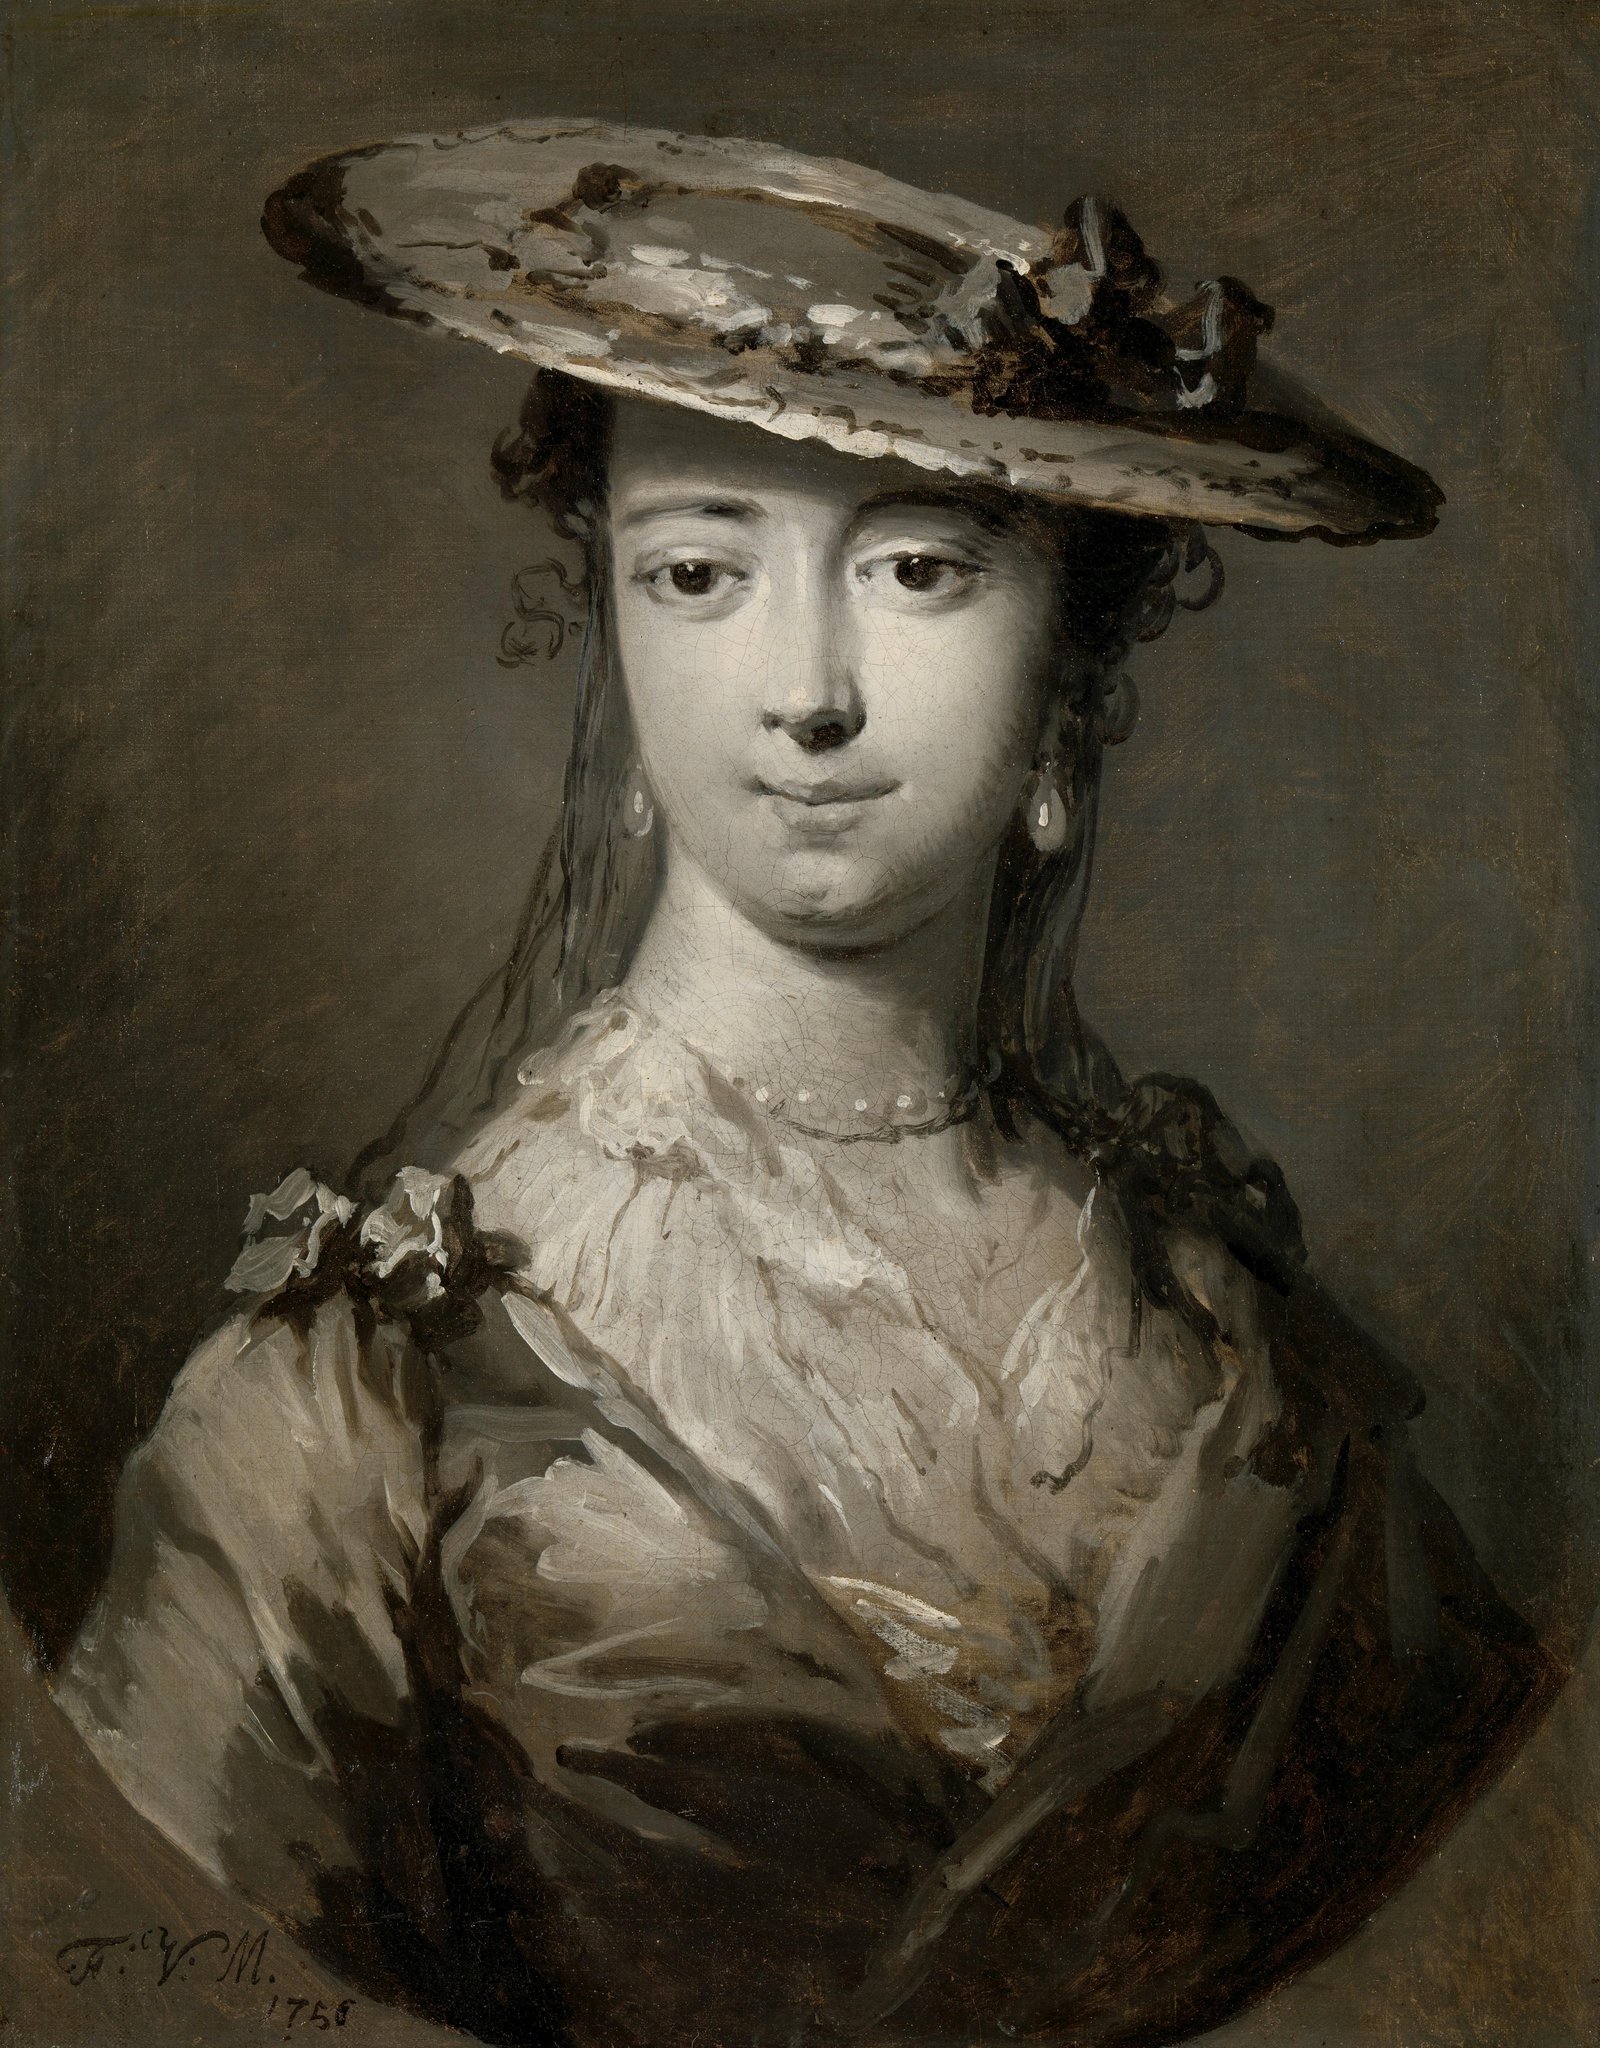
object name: grisaille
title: Head of a Young Woman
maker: frans van der mijn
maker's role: painter, print maker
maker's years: 1719-1783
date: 1756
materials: canvas, oil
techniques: grisaille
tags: adolescent, young woman, maiden, historical persons not known by name - bb - woman, pearl; pearl necklace (+ women's clothes)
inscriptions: signature and date: ‘F: V: M. 1756’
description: Frans van der Mijn was just a child when he moved with his father Herman to London, where he would make a career for himself. This painting is not a portrait, but an idealized, imaginary rendering of a young woman. The use of brown, grey and white tones imitates graphic art. With this painterly device, Van der Mijn showed off his artistic skills.